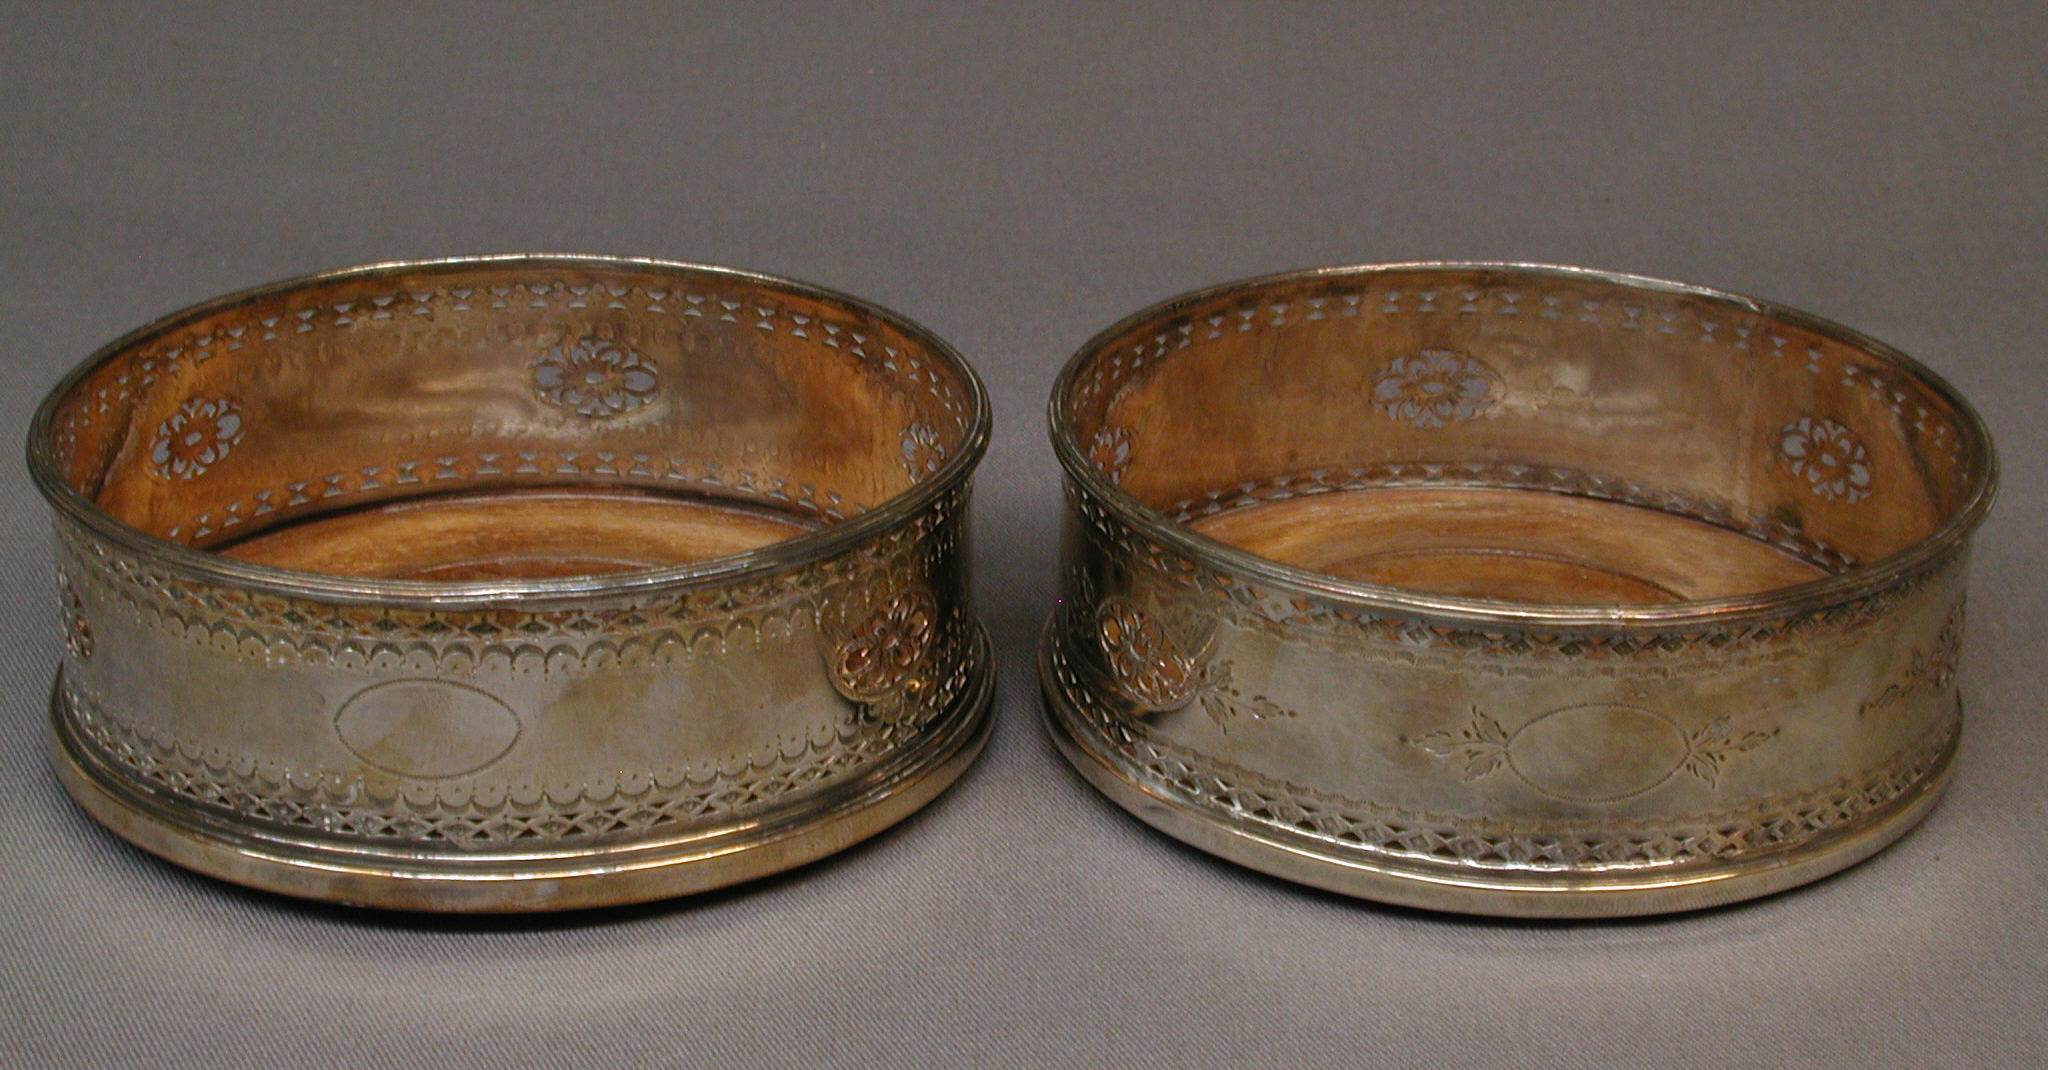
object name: coaster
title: Two coasters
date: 1785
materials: metal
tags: flowers